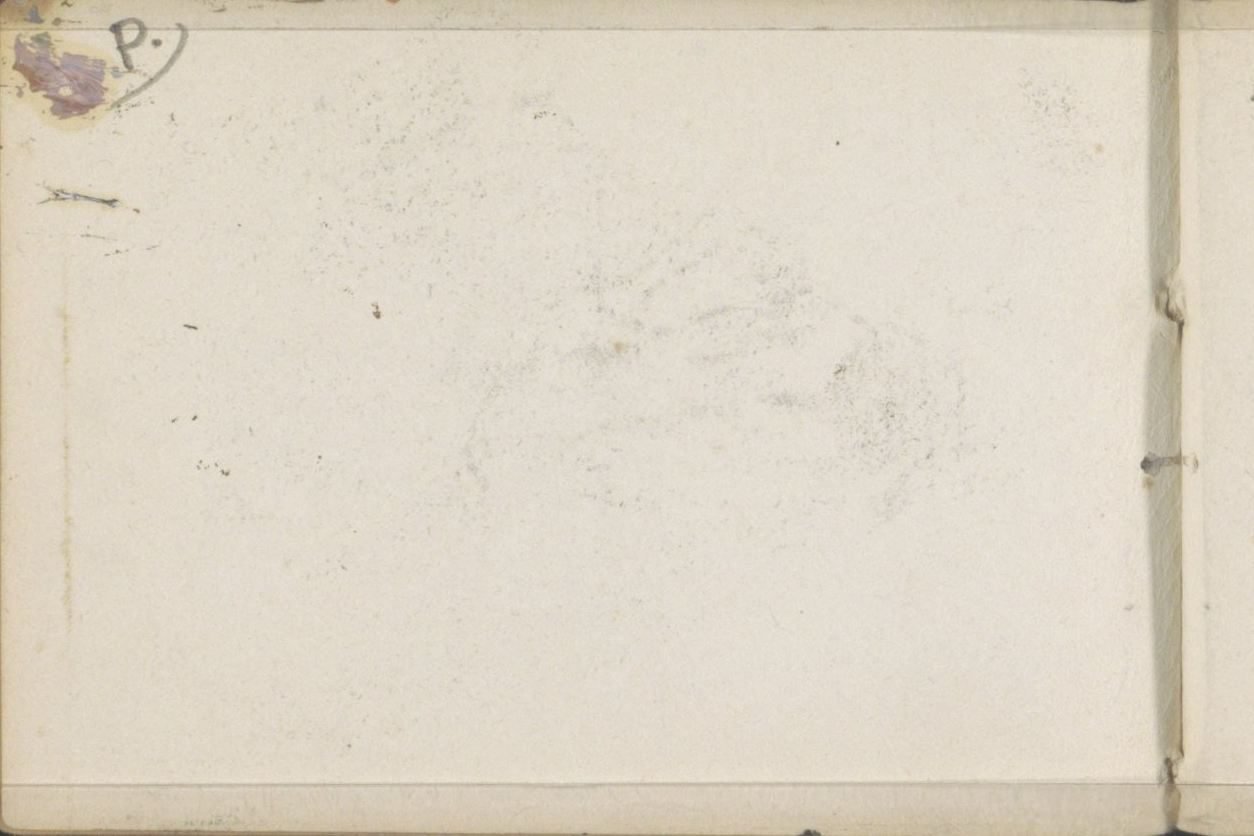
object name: sketchbook leaf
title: Annotatie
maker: marius bauer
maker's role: draughtsman, print maker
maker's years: 1867-1932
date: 1922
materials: paper, pencil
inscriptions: annotation: ‘P.)’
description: Pagina 2 uit een schetsboek met 32 bladen.